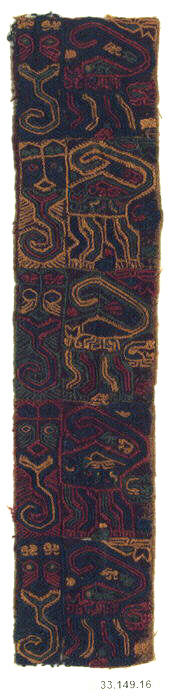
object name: border fragment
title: Embroidered Border Fragment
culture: paracas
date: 500-101 BCE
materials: animal fiber, cotton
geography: peru